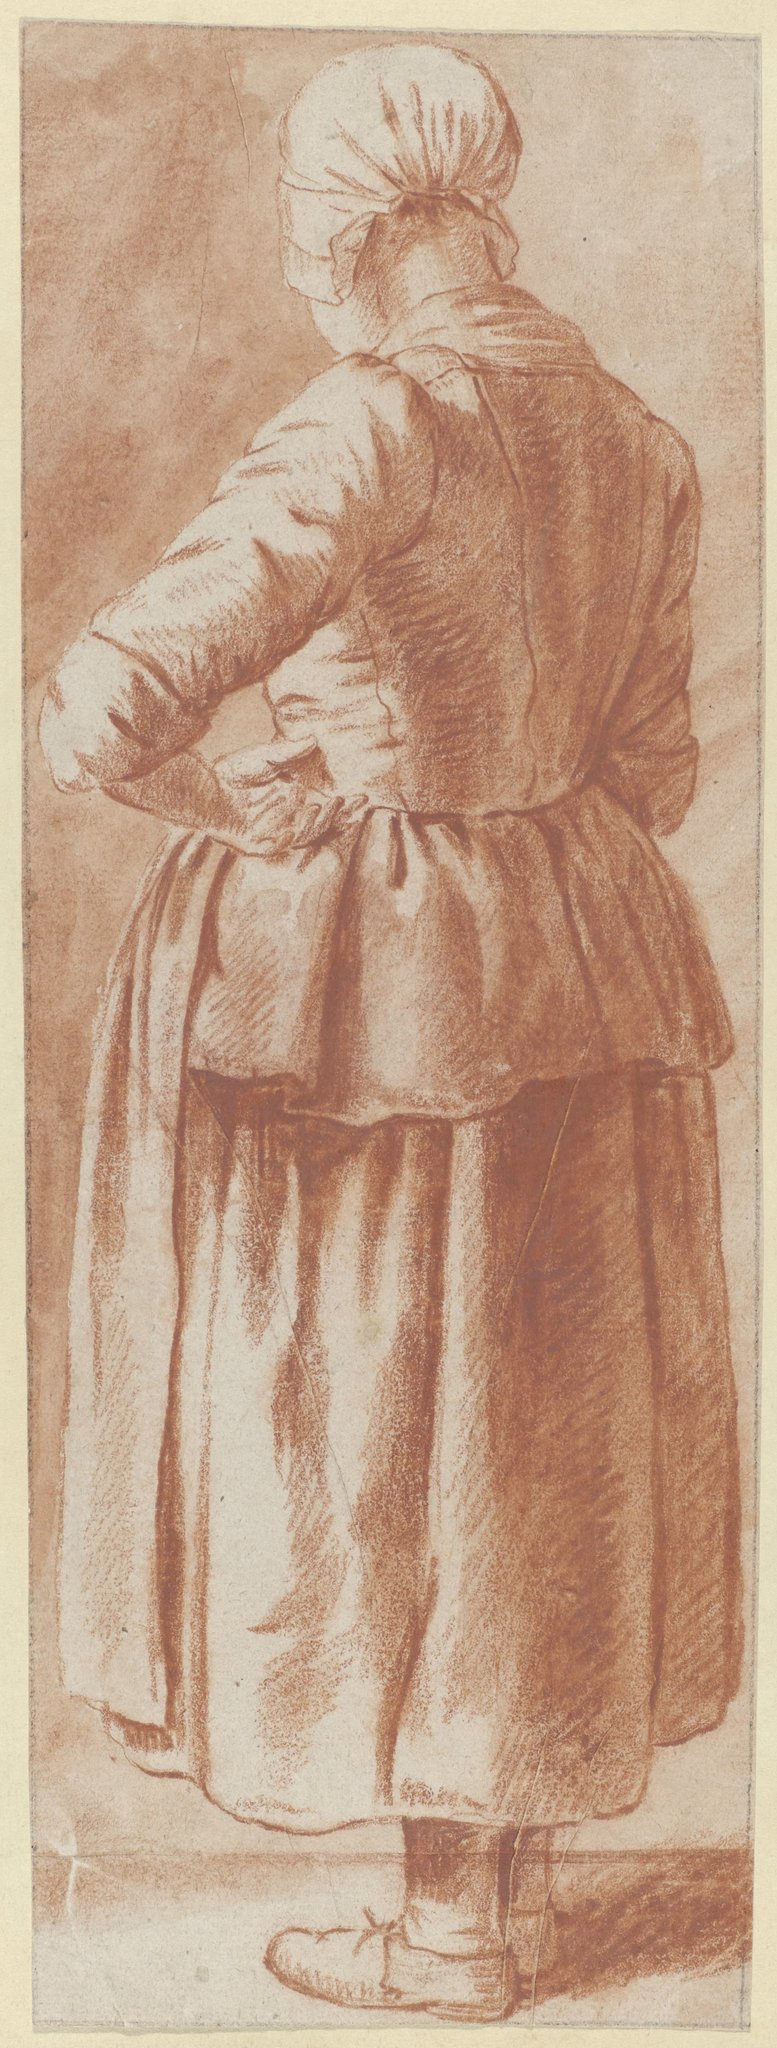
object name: drawing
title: Staande vrouw met muts, op de rug gezien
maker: Anonymous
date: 1600-1699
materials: chalk, paper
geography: netherlands